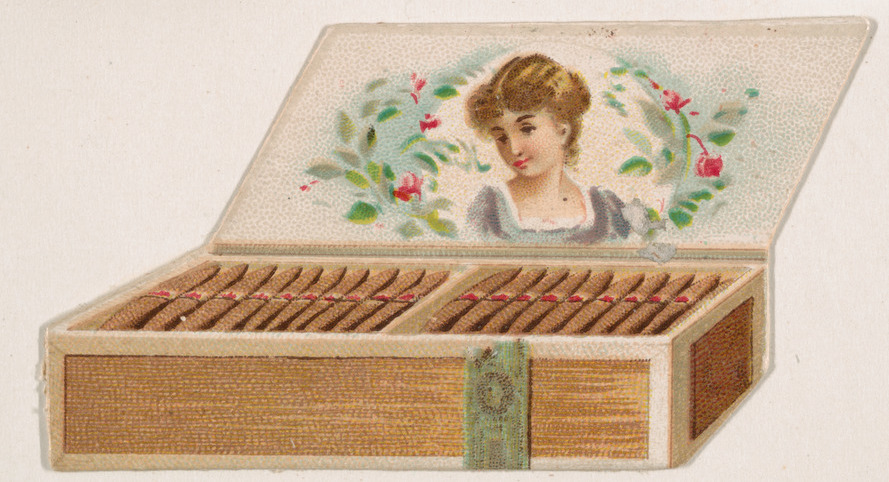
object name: print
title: Cigar box, from the Novelties series (N228, Type 3) issued by Kinney Bros.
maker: kinney brothers tobacco company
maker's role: publisher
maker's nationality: american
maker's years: 1869-2011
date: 1889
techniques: color lithograph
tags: women